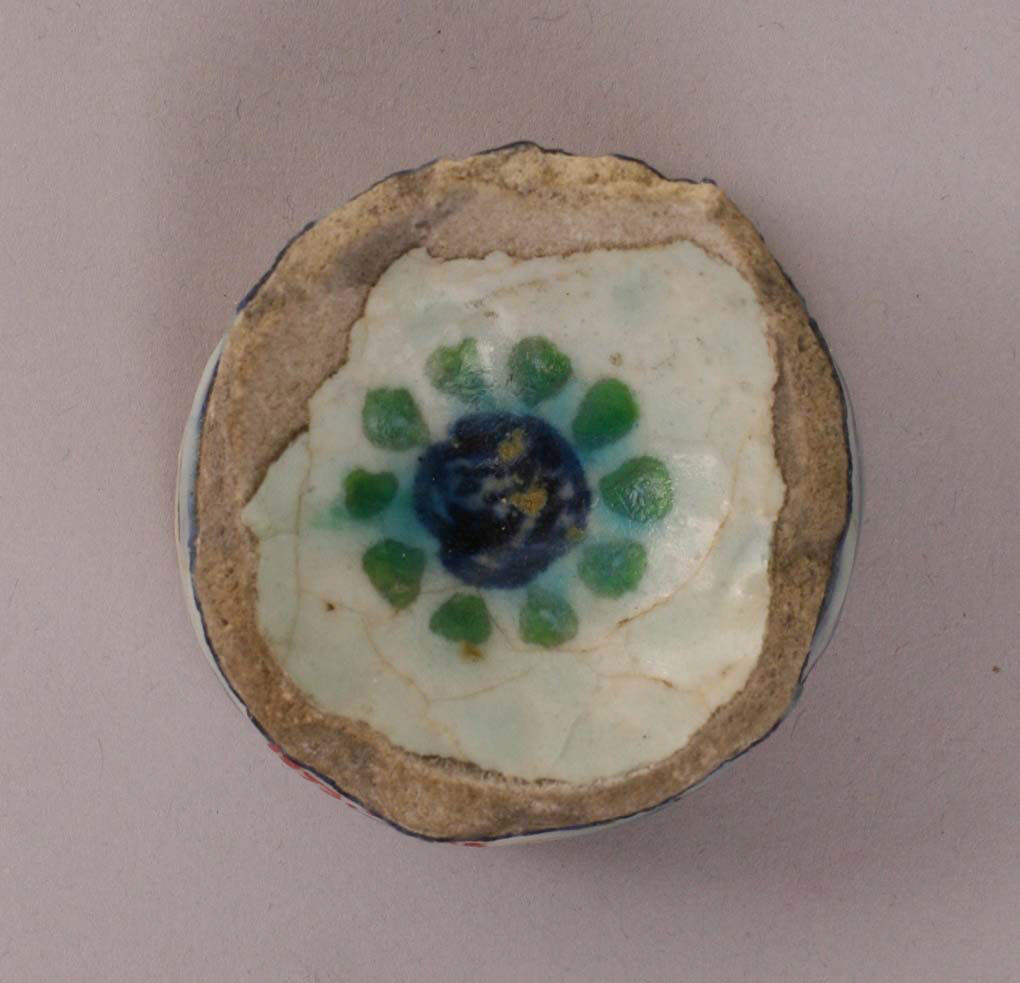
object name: fragment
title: Fragment of a Bowl or Cup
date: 1201-1600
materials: glaze, stonepaste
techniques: painting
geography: egypt